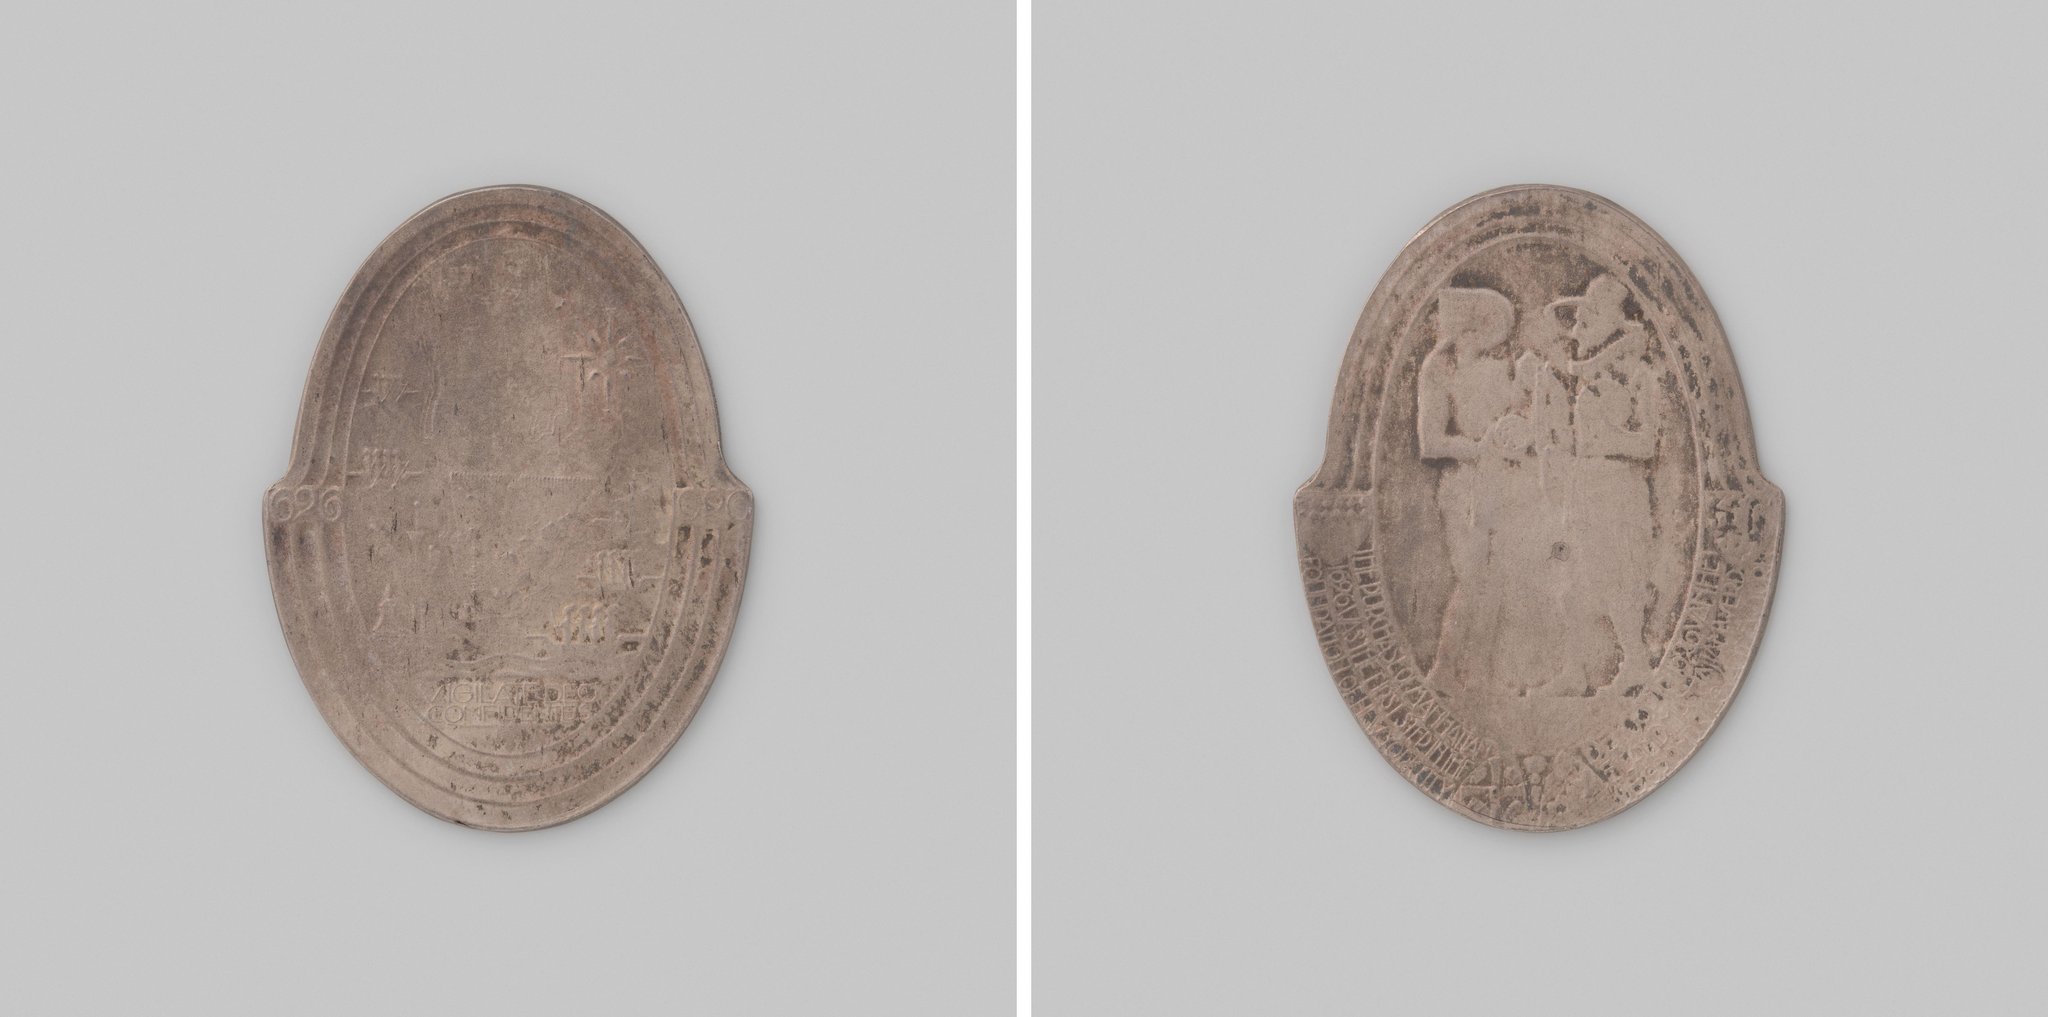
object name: medal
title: Derde eeuwfeest van de stichting van New York door de Nederlanders, 1926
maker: Anonymous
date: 1926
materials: silver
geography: netherlands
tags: new york (city)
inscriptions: date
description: Zilveren ovale penning van het derde eeuwfeest van de stichting van New York door de Nederlanders, 1926. Voorzijde: plattegrond van Nieuw Amsterdam (New York); keerzijde: tegenover elkaar staande Nederlander en een vertegenwoordiger van de Lenape, de bewoners van Manhattan (verbeelding van de 'aankoop' van Manhattan)